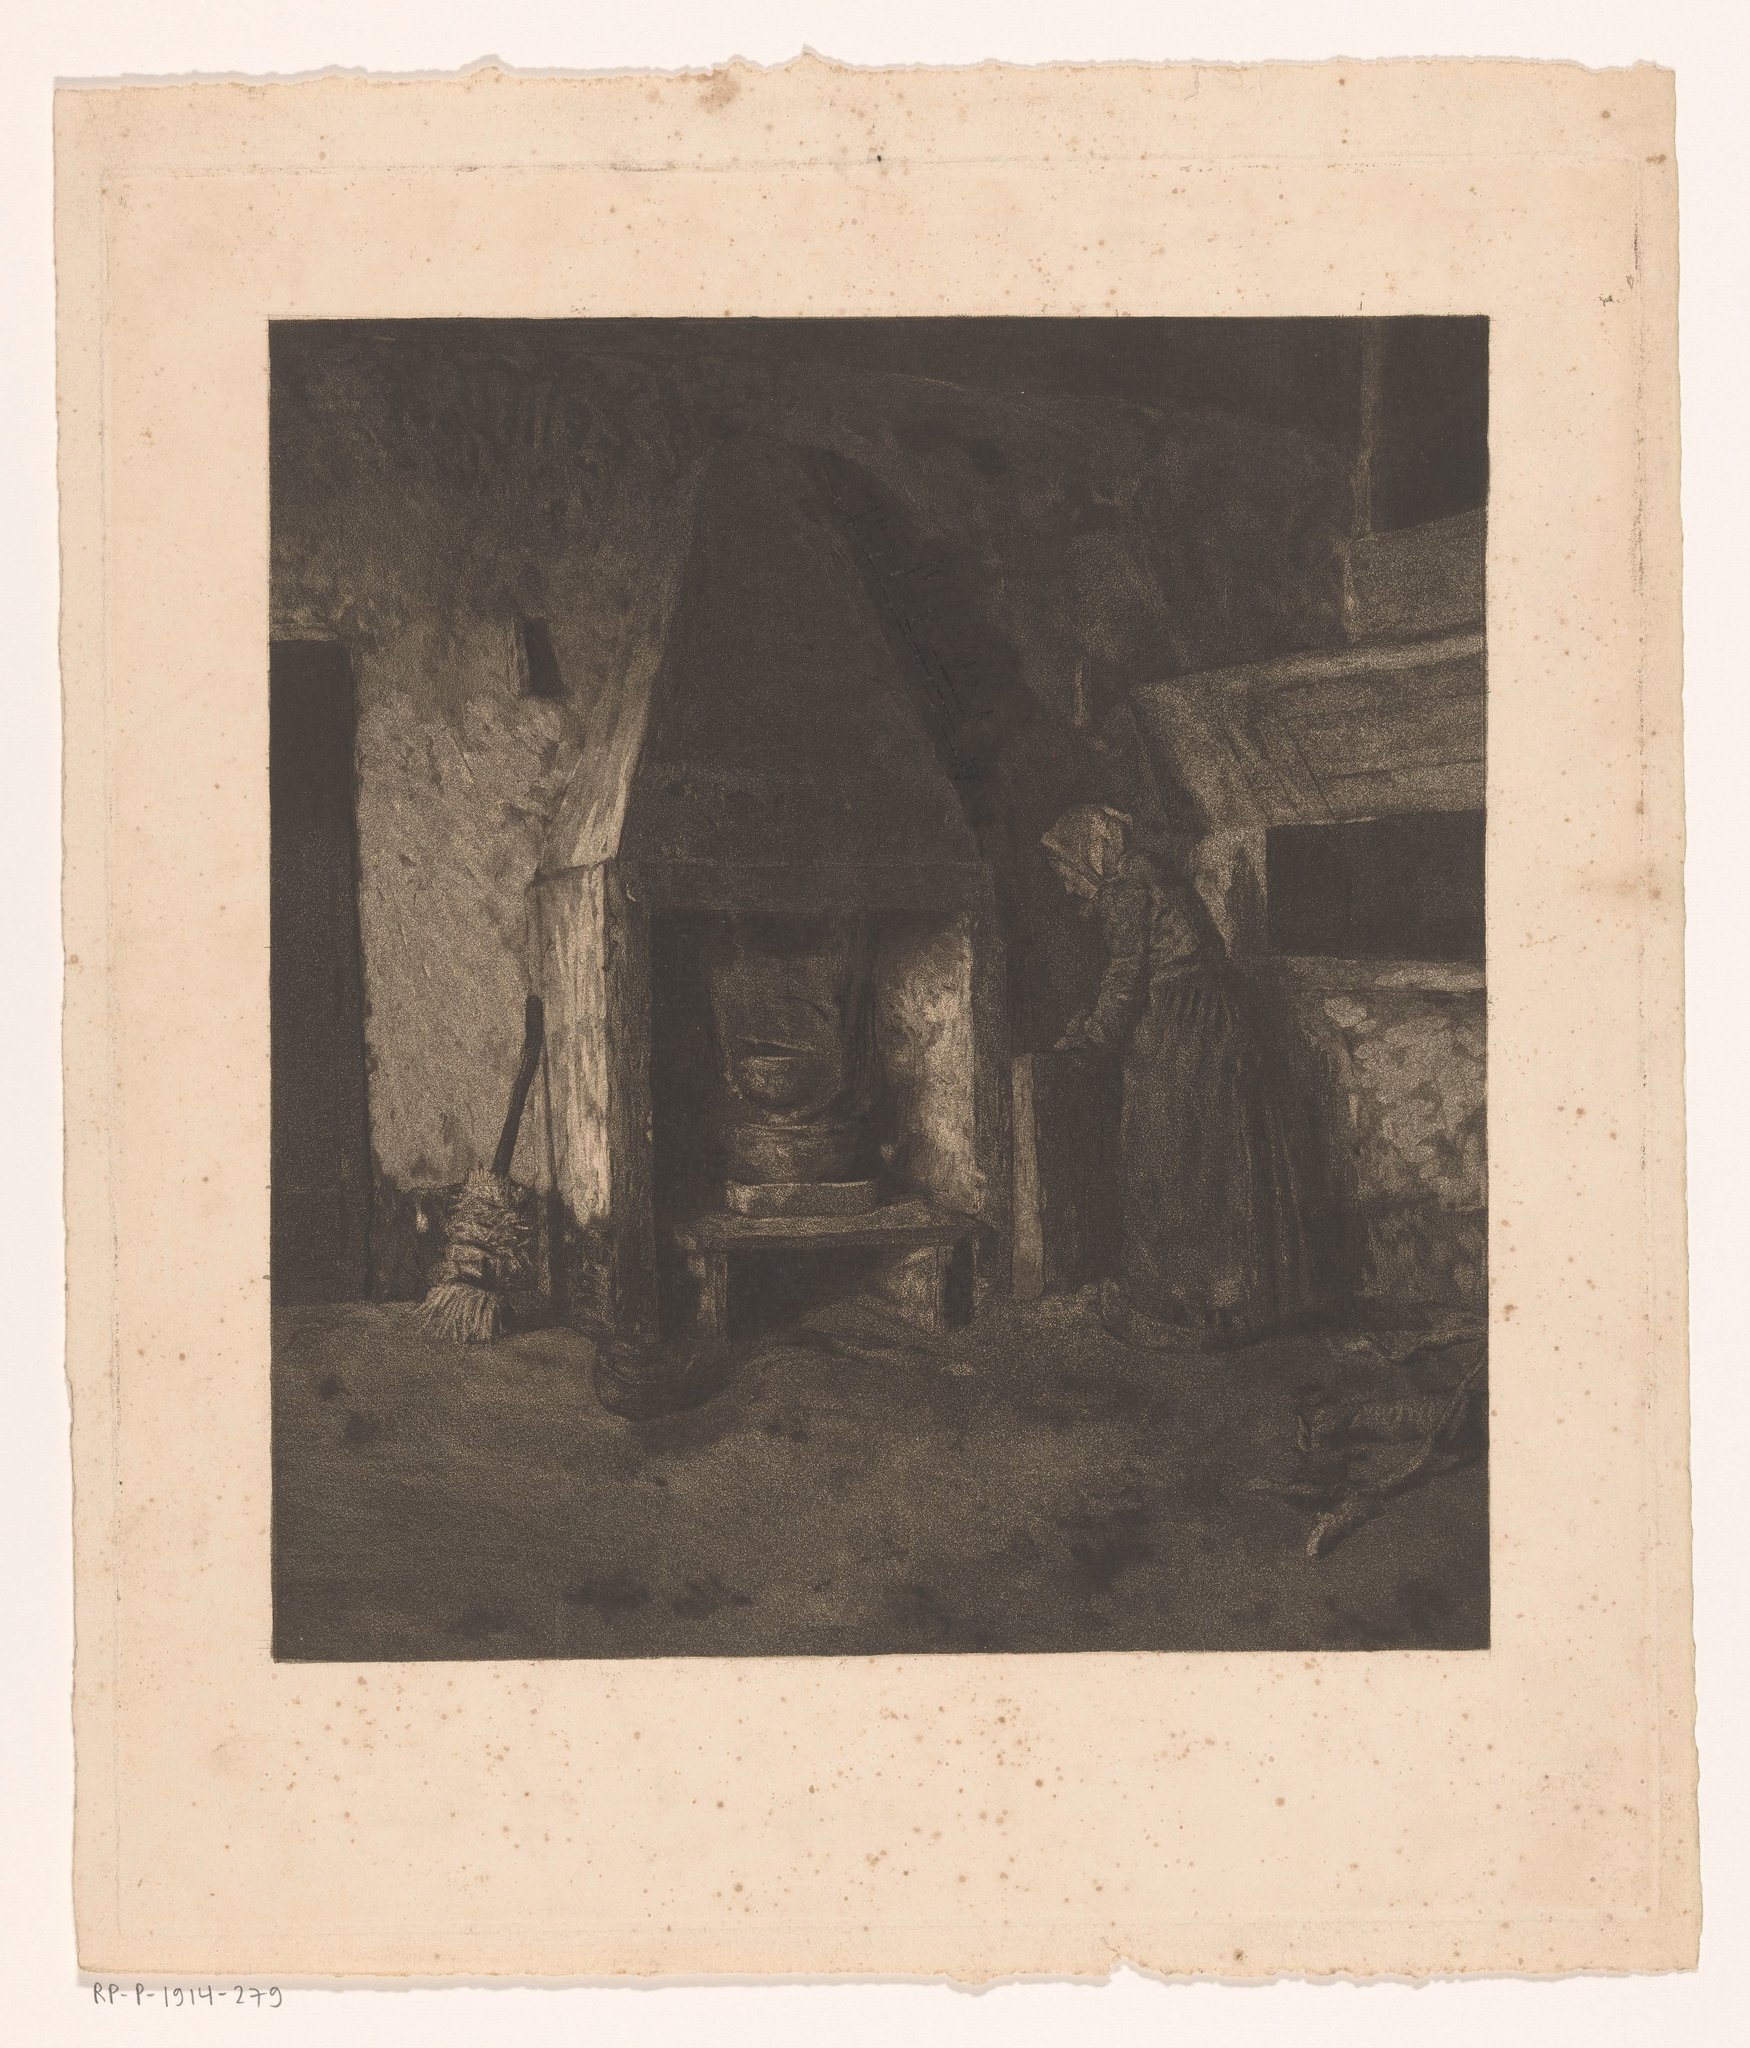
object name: print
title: Boerenvrouw staand bij een haard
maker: emanuel samson van beever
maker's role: draughtsman, painter, print maker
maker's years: 1876-1912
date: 1886-1912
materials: paper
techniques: aquatint, etching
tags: open hearth, fire-place, farm (building) - aa - civic architecture: inside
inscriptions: collector's mark: Lugt 2233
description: De vrouw draagt een hoofddoek. Tegen de haard leunt een bezem.